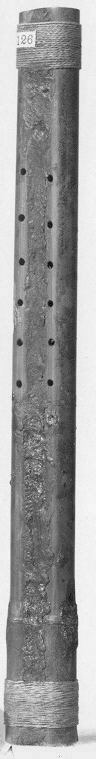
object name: double clarinet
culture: indian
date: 1801-1900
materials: wax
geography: india